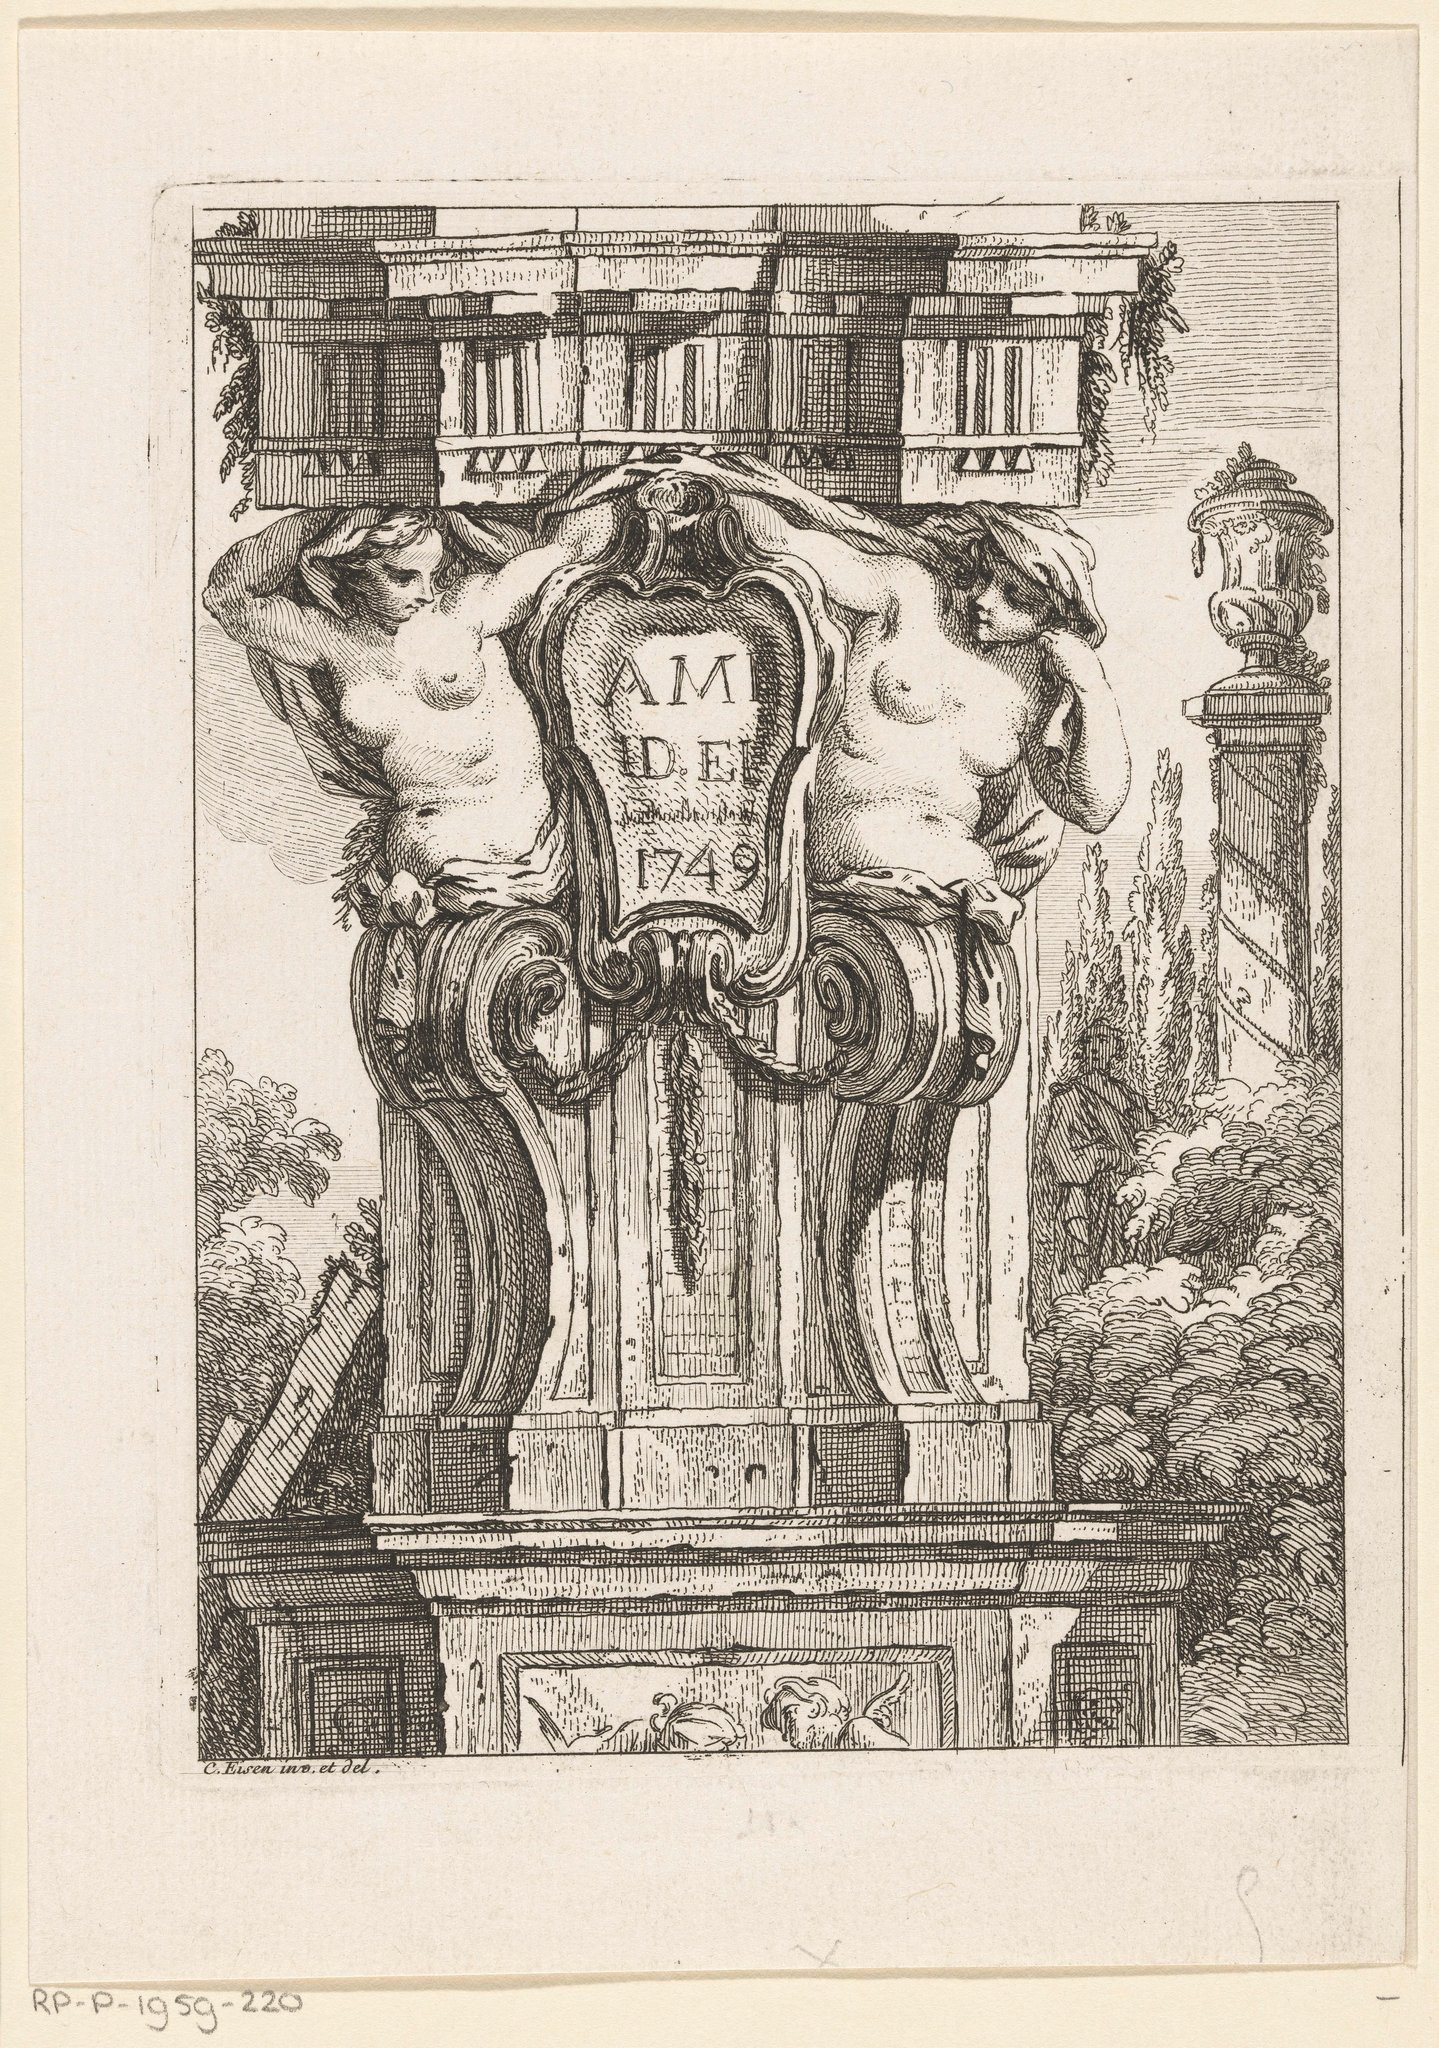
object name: print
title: Voetstuk met halffiguren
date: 1749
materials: paper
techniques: etching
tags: pedestal of a piece of sculpture (perhaps in the form of a herm), ornament ~ cartouche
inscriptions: collector's mark: Lugt 2760, collector's mark: Lugt 2228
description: Voetstuk met twee vrouwelijke halffiguren aan weerszijden van een cartouche met tekst AM / ID. EI / 1749. Rechts in het landschap staat een man naast een vaas op een zuil.